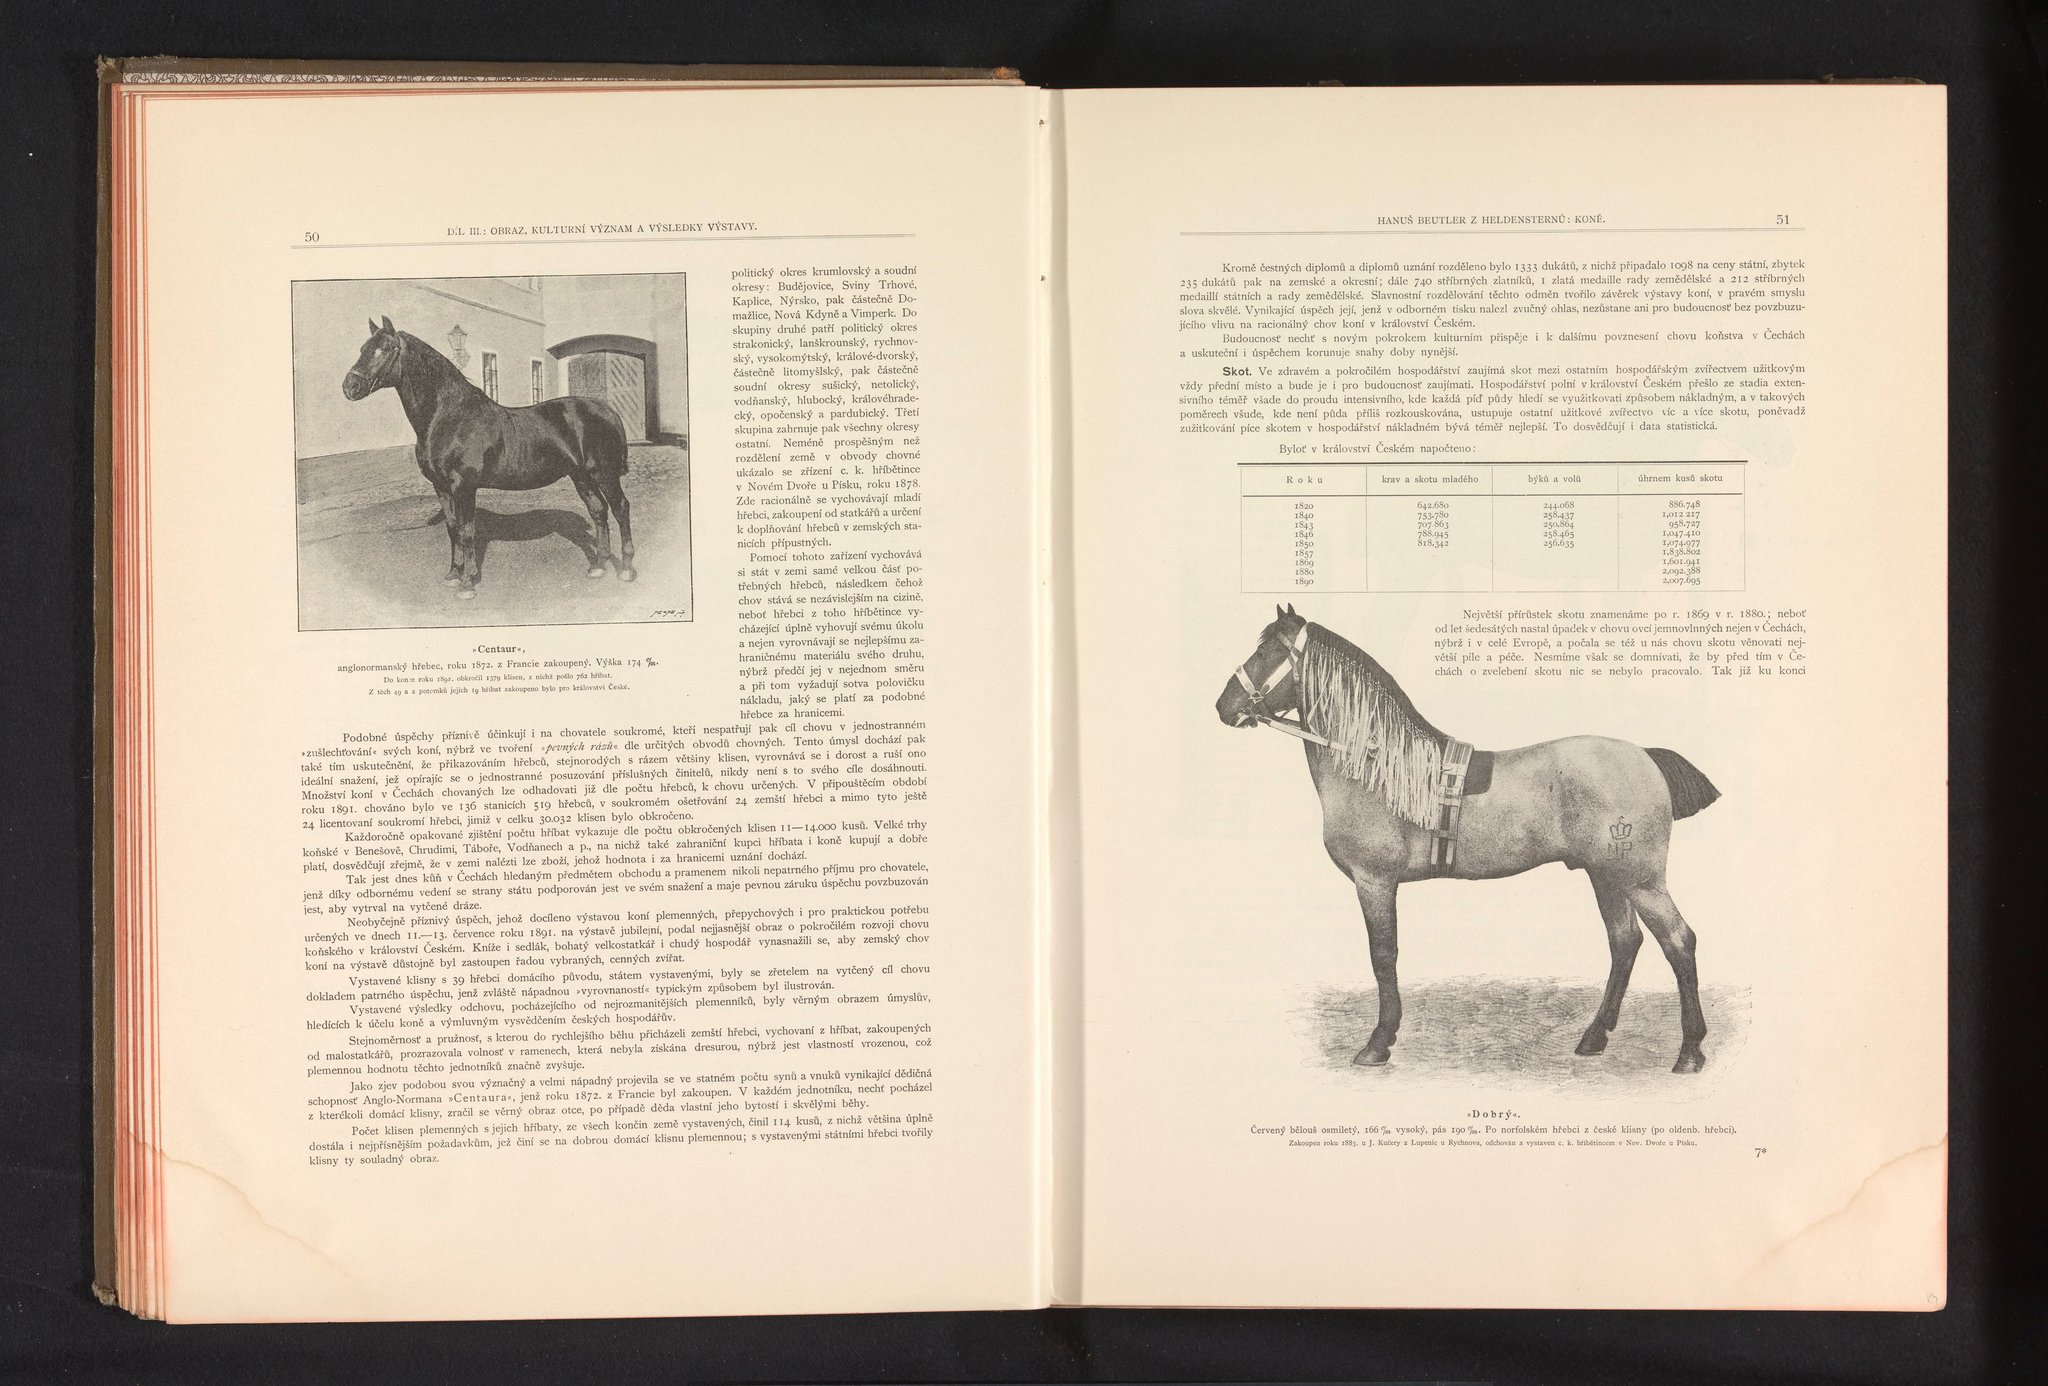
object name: photomechanical print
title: ,,Centaur"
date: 1891-1895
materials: paper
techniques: autotype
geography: prague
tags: horse